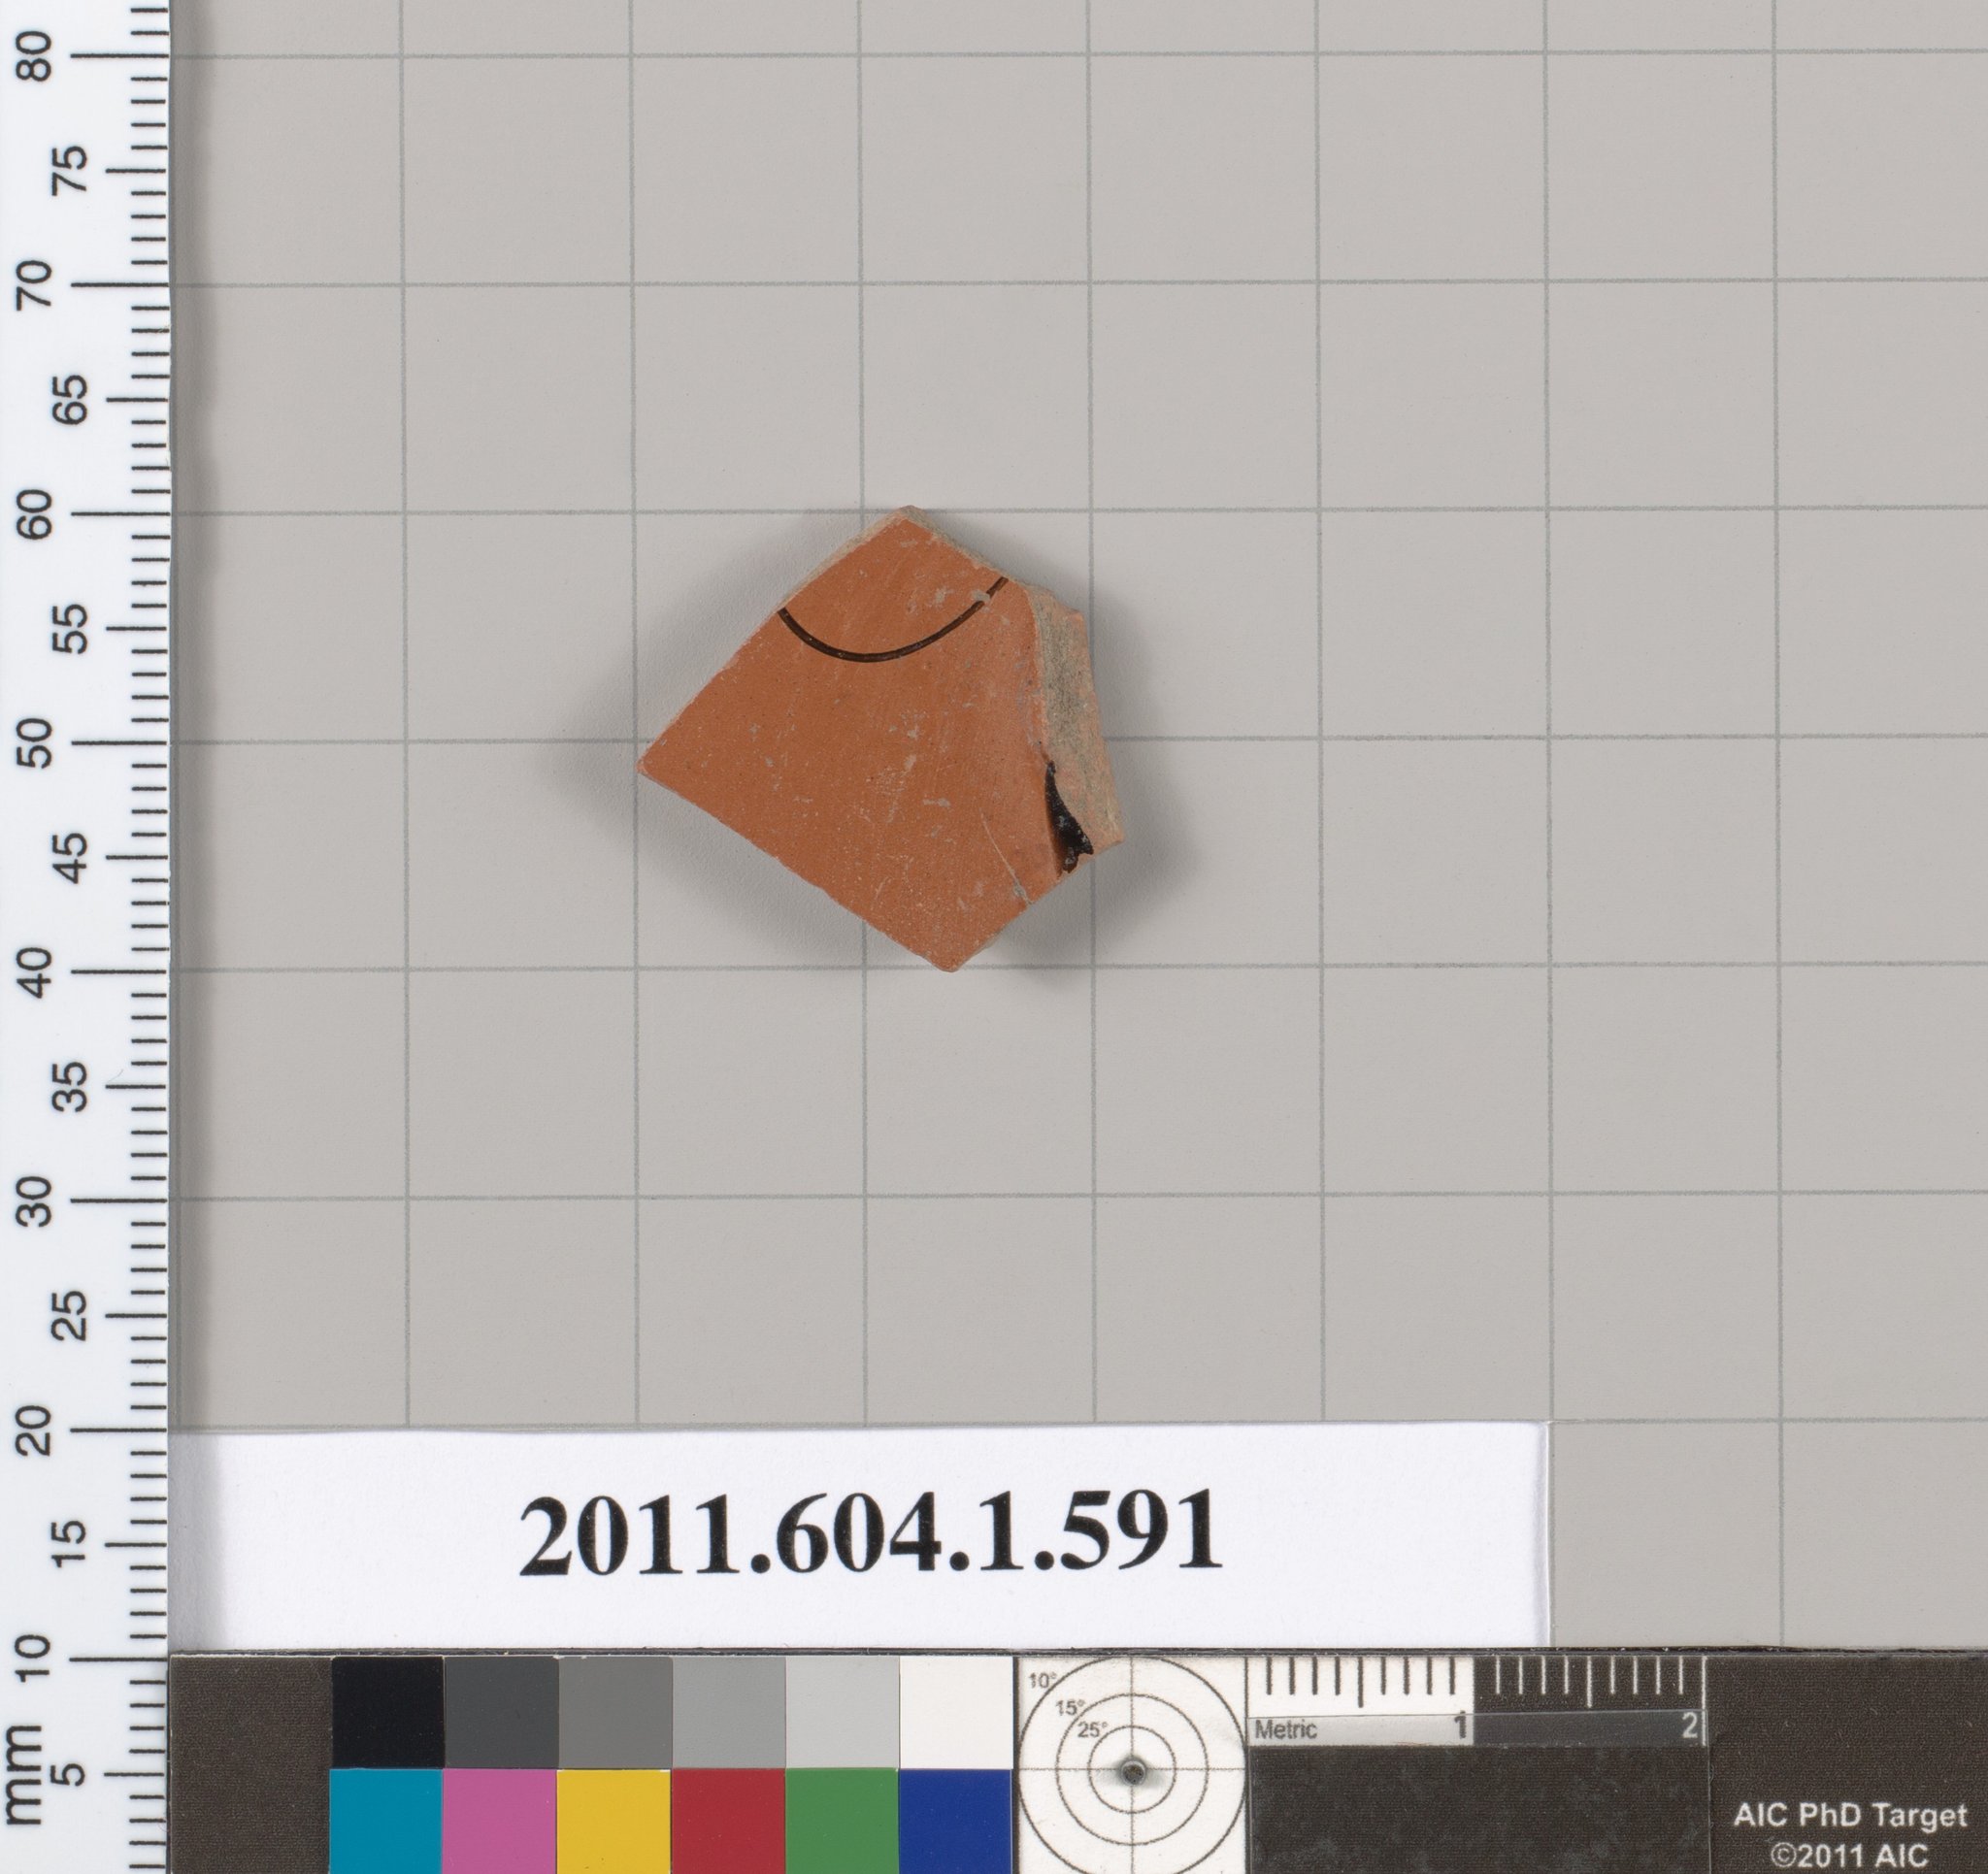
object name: kylix fragment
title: Terracotta fragment of a kylix (drinking cup)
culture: greek, attic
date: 475-451 BCE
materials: terracotta